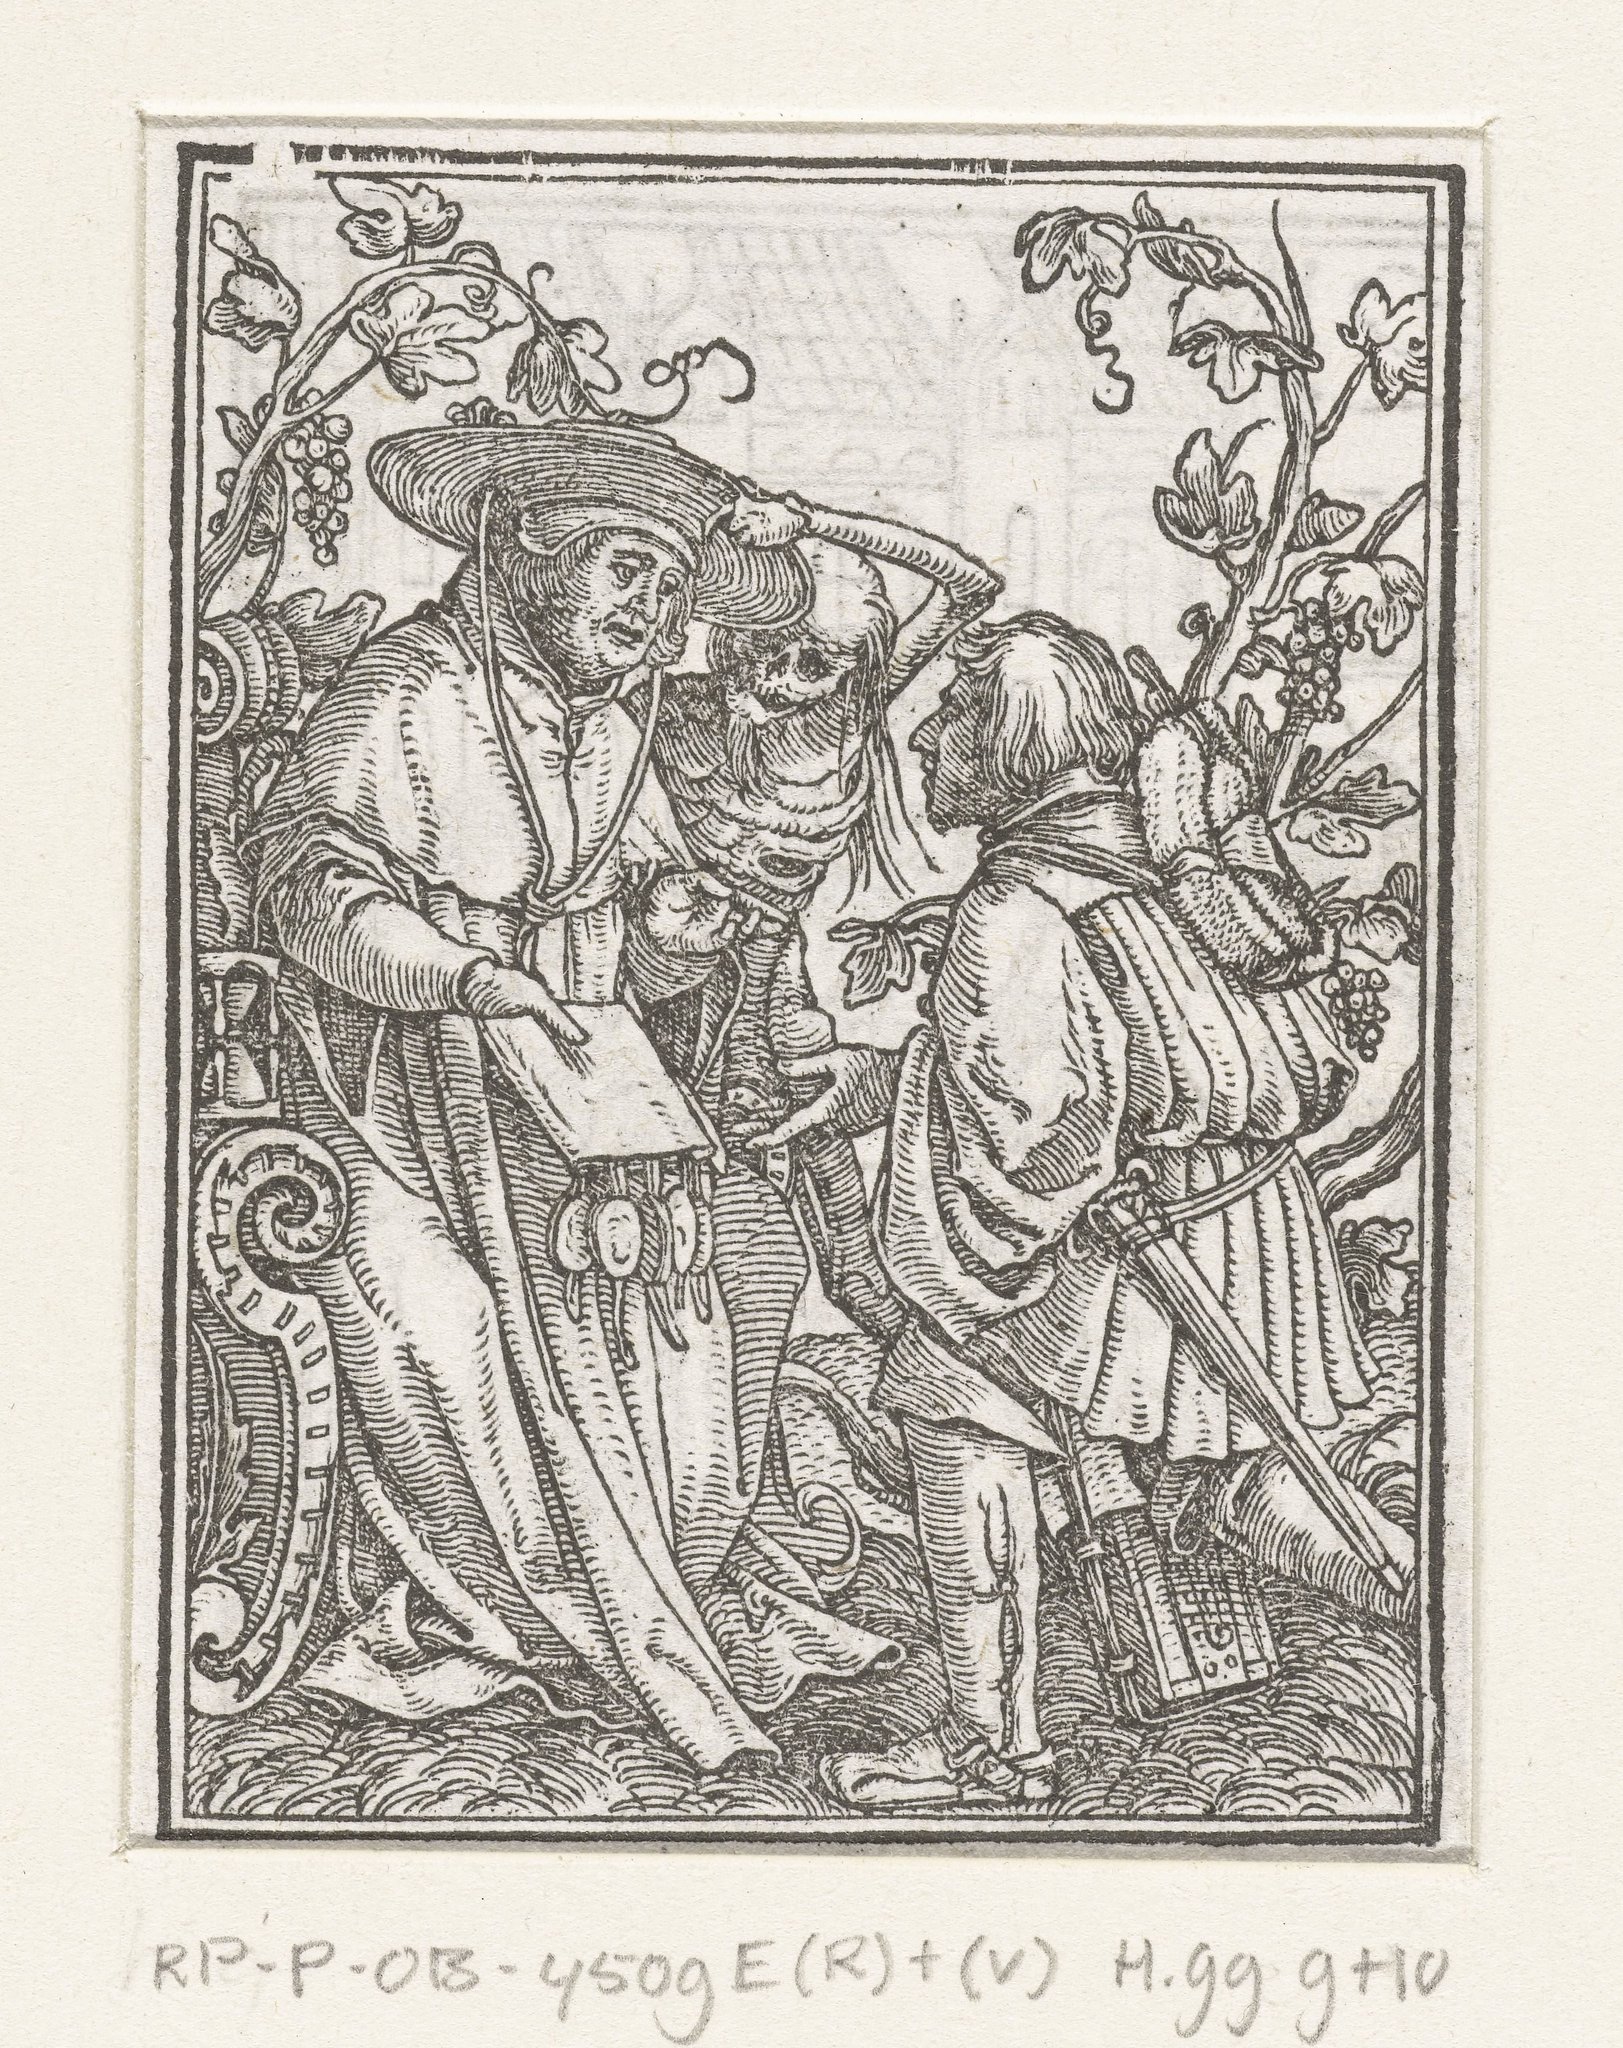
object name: print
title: Kardinaal en de Dood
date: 1524-1526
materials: paper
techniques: woodcut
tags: cardinal, dance of death; death together with one or more human beings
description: De houtblokken werden voor 1526 vervaardigd door Hans Lützelburg en pas in 1538 voor het eerst gebruikt als boekillustraties in: Les simulachres & historiees faces de la mort avtant elegamment pourtraictes que artificiellement imaginées... a Lyon, Soubsz l'escu de Coloigne, MDXXXVIII, (M. en G. Trechsel, voor F. Frellon in Lyon), 1538. Later verschenen nog andere uitgaven.